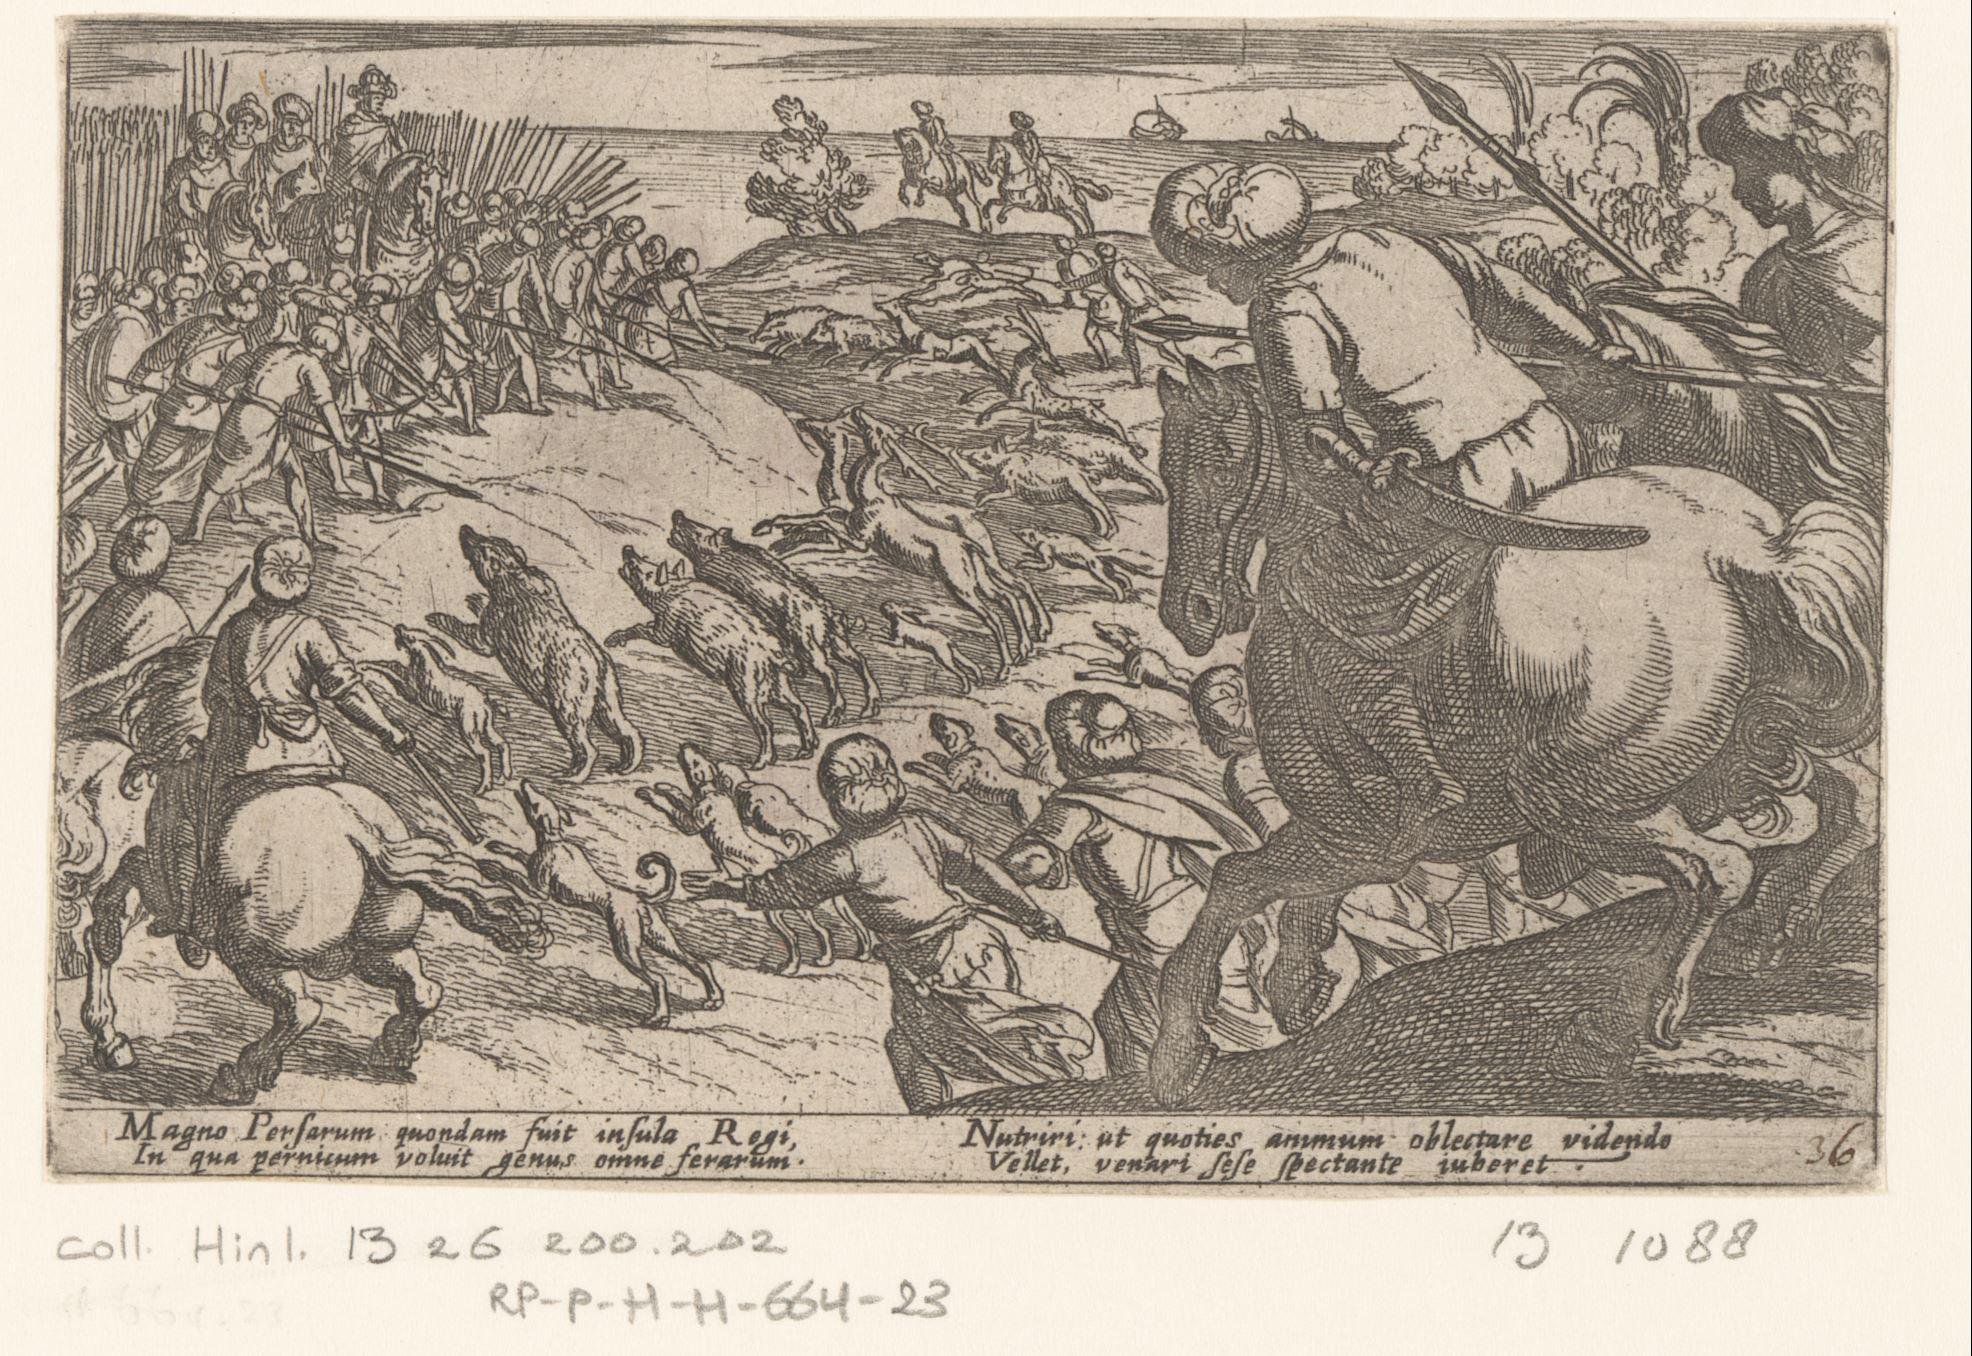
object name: print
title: Jagers vangen groep wilde dieren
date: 1605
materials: paper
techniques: etching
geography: italy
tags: hunter, hunters hunting (n.b.: in 1988-1990 this notation denoted the concept of 43c11421 'hunters resting during the hunt')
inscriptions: number: ‘36’, collector's mark: ‘Hinloopen’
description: Landschap met een grote groep jagers te paard die een groep wilde dieren insluit. Tekst in het Latijn in ondermarge.